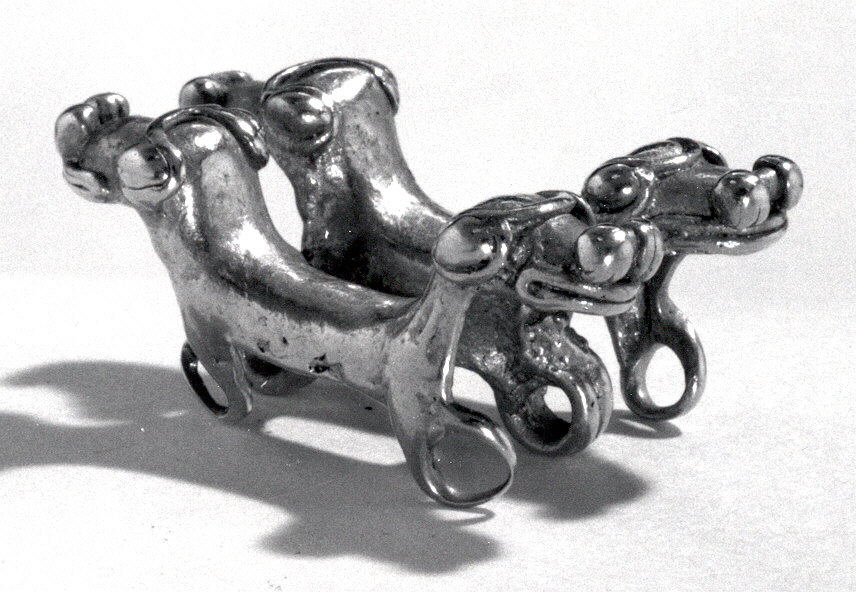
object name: pendant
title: Double-Animal Pendant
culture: conte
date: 501-800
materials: gold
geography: panama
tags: animals